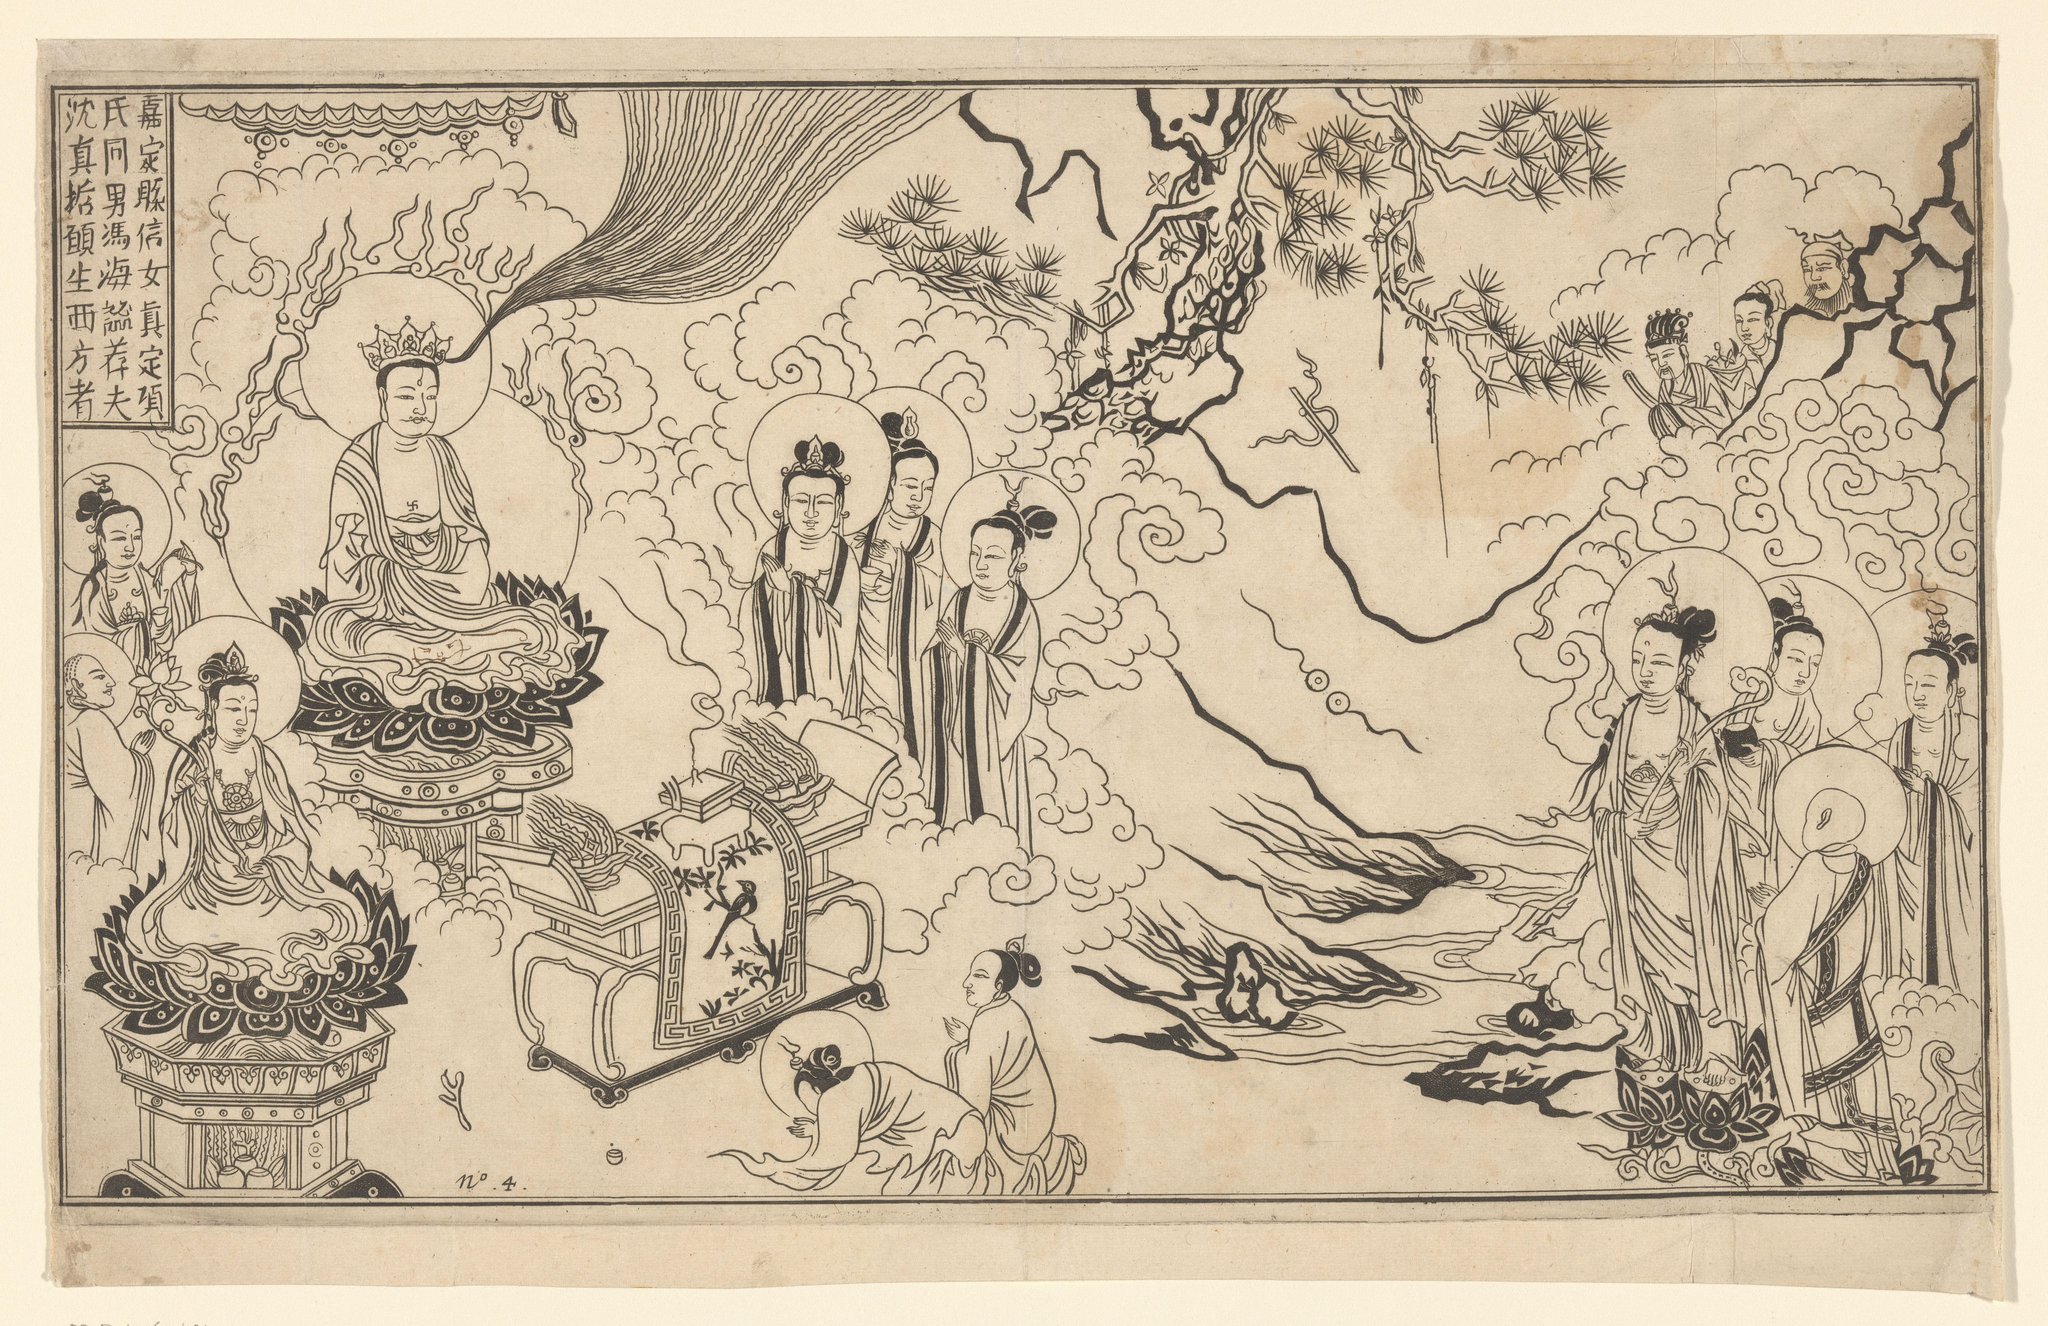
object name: print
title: Blad vier uit een reeks van vier bladen met Chinese voorstellingen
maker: Anonymous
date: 1670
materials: paper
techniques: engraving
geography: amsterdam